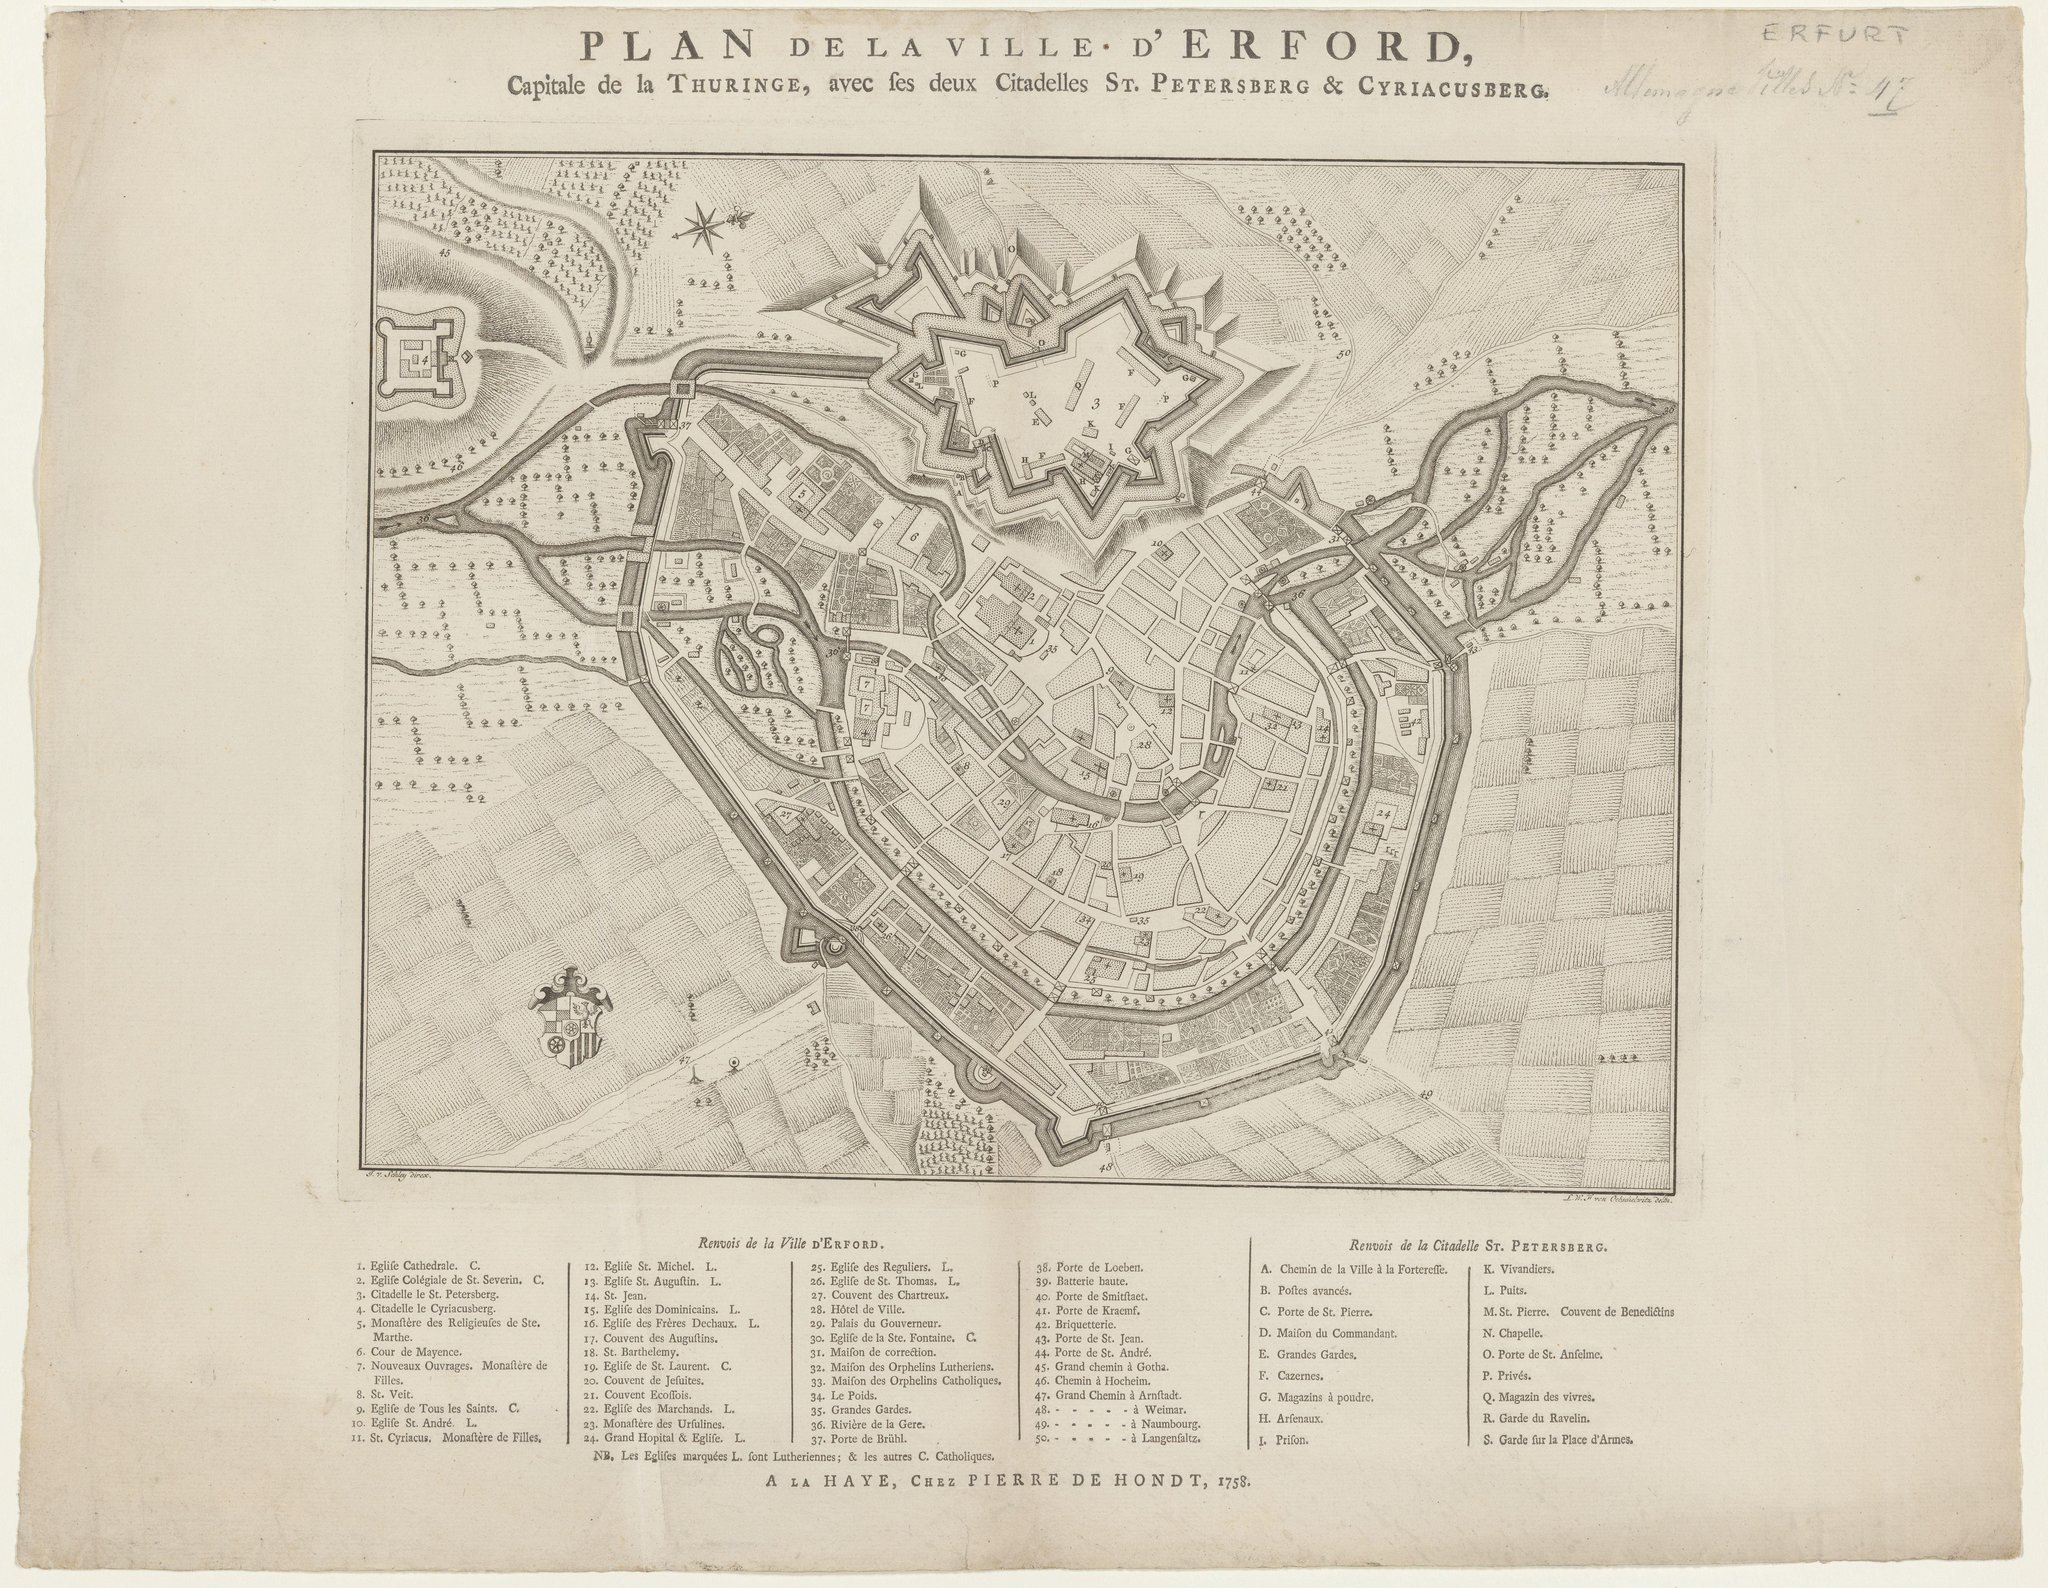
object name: area plan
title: Plan de la ville d'Erford, captiale de la Thuringe, avec ses deux citadelles (...)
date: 1758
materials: paper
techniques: etching, letterpress printing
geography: the hague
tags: coat of arms (as symbol of the state, etc.) (+ city; municipal), maps of cities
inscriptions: collector's mark: Lugt 2228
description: Linksonder een wapen van Erfurt. Met Franse tekst in boekdruk op recto.